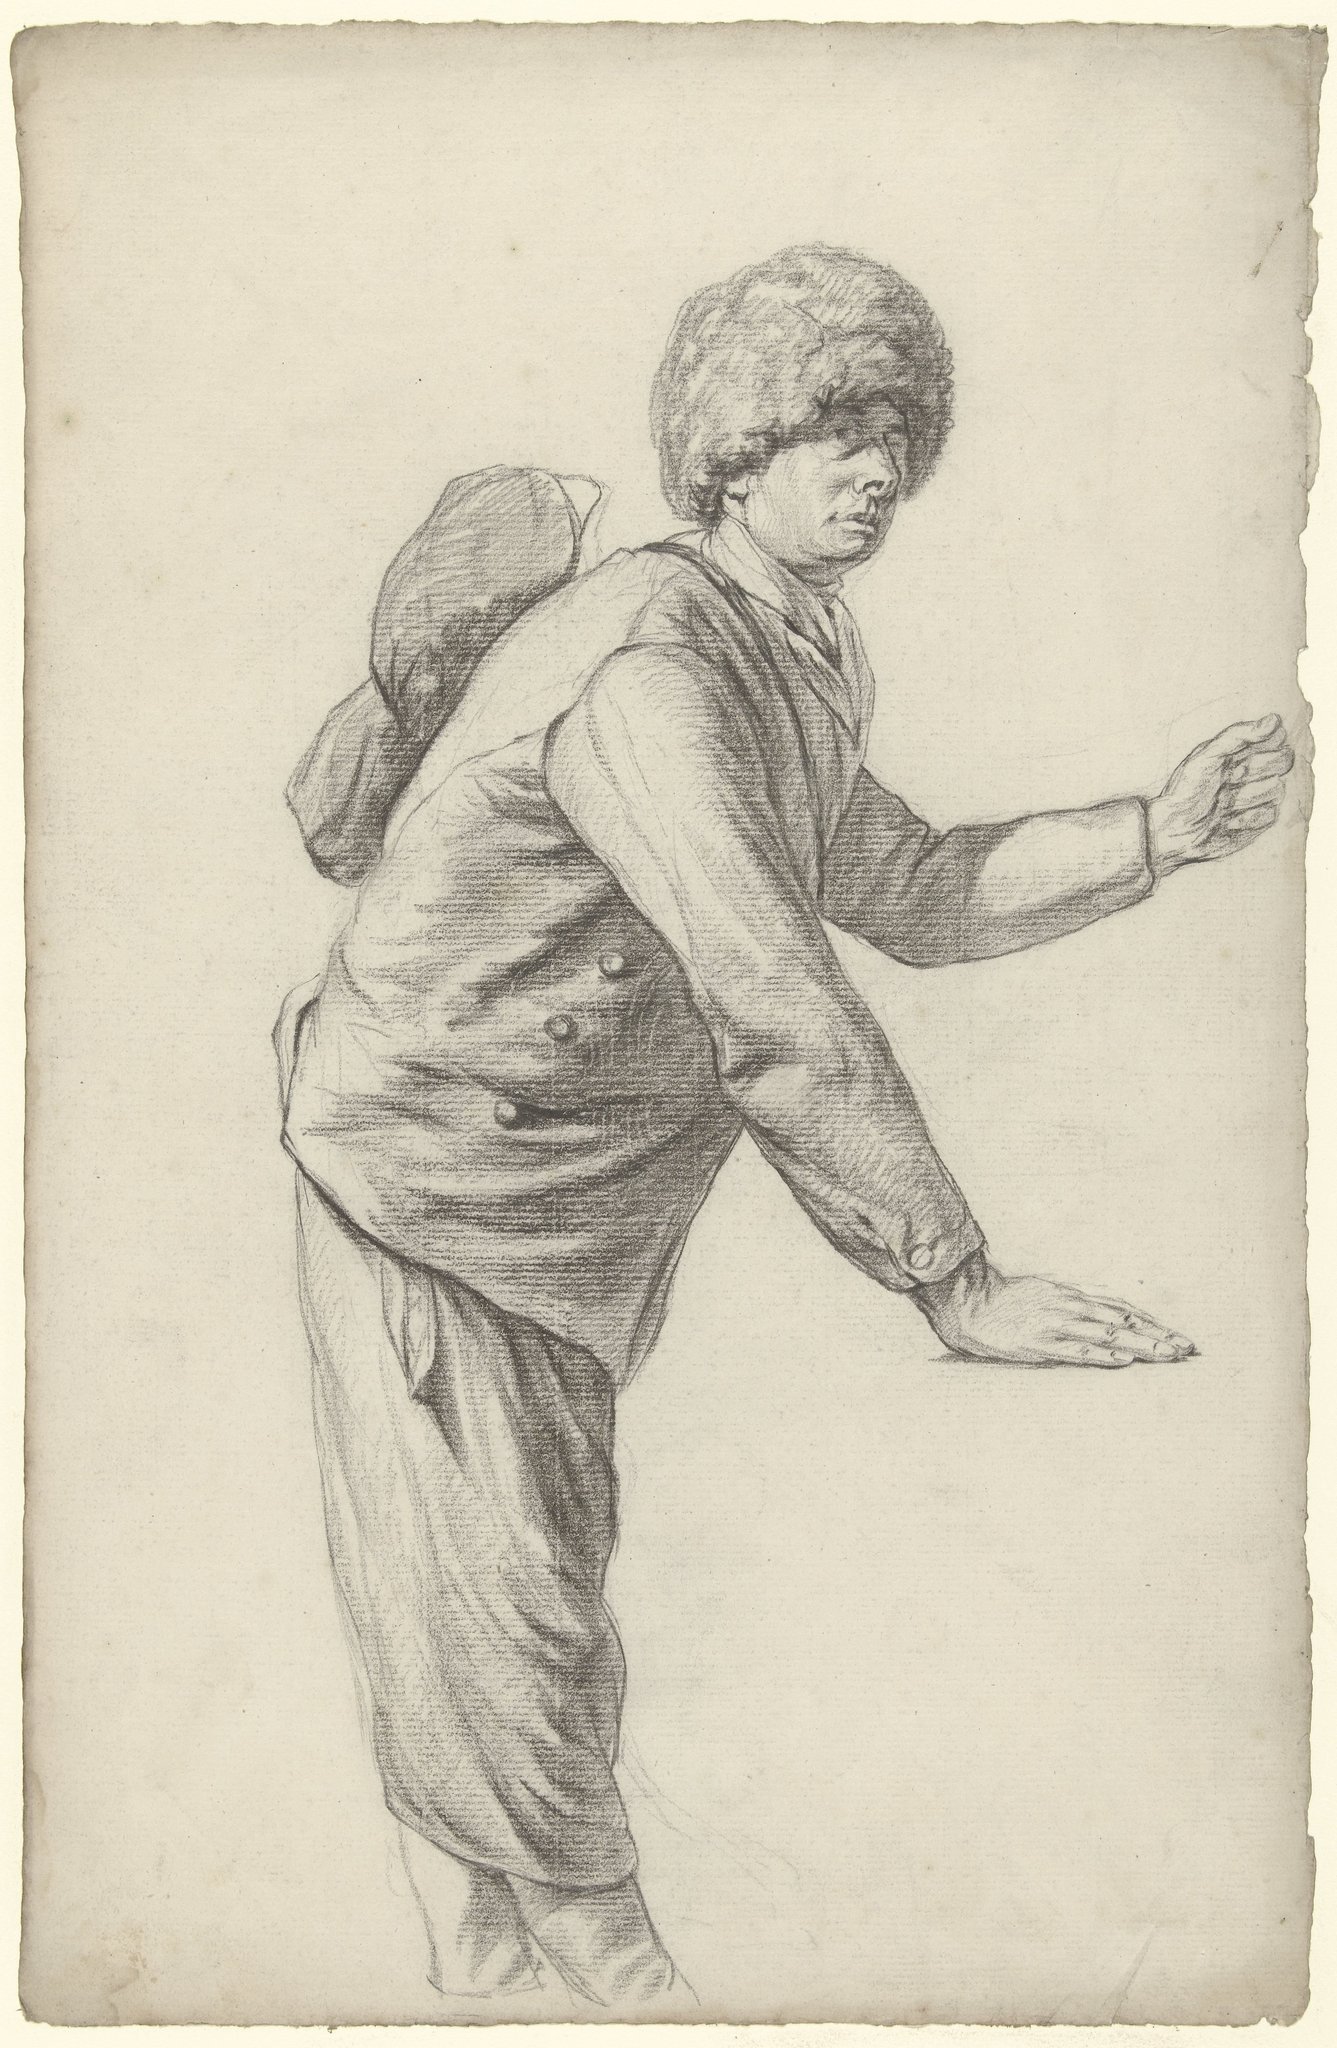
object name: drawing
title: Staande man met bontmuts en pak op de rug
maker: Anonymous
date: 1700-1800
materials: chalk, paper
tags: standing figure